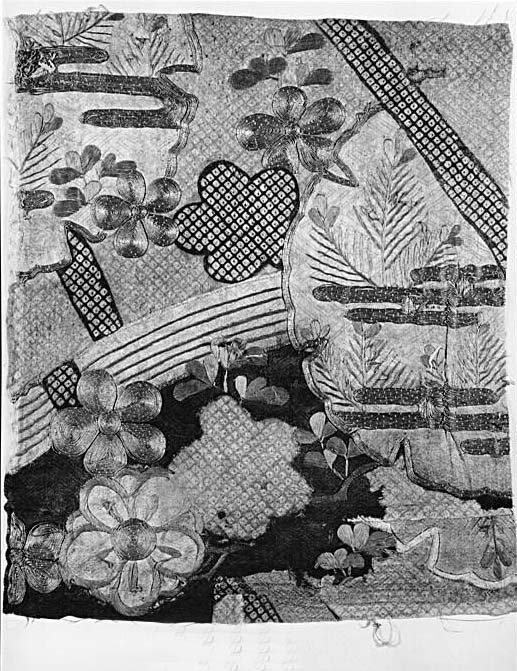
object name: piece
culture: japanese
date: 1700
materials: metal thread, silk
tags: flowers